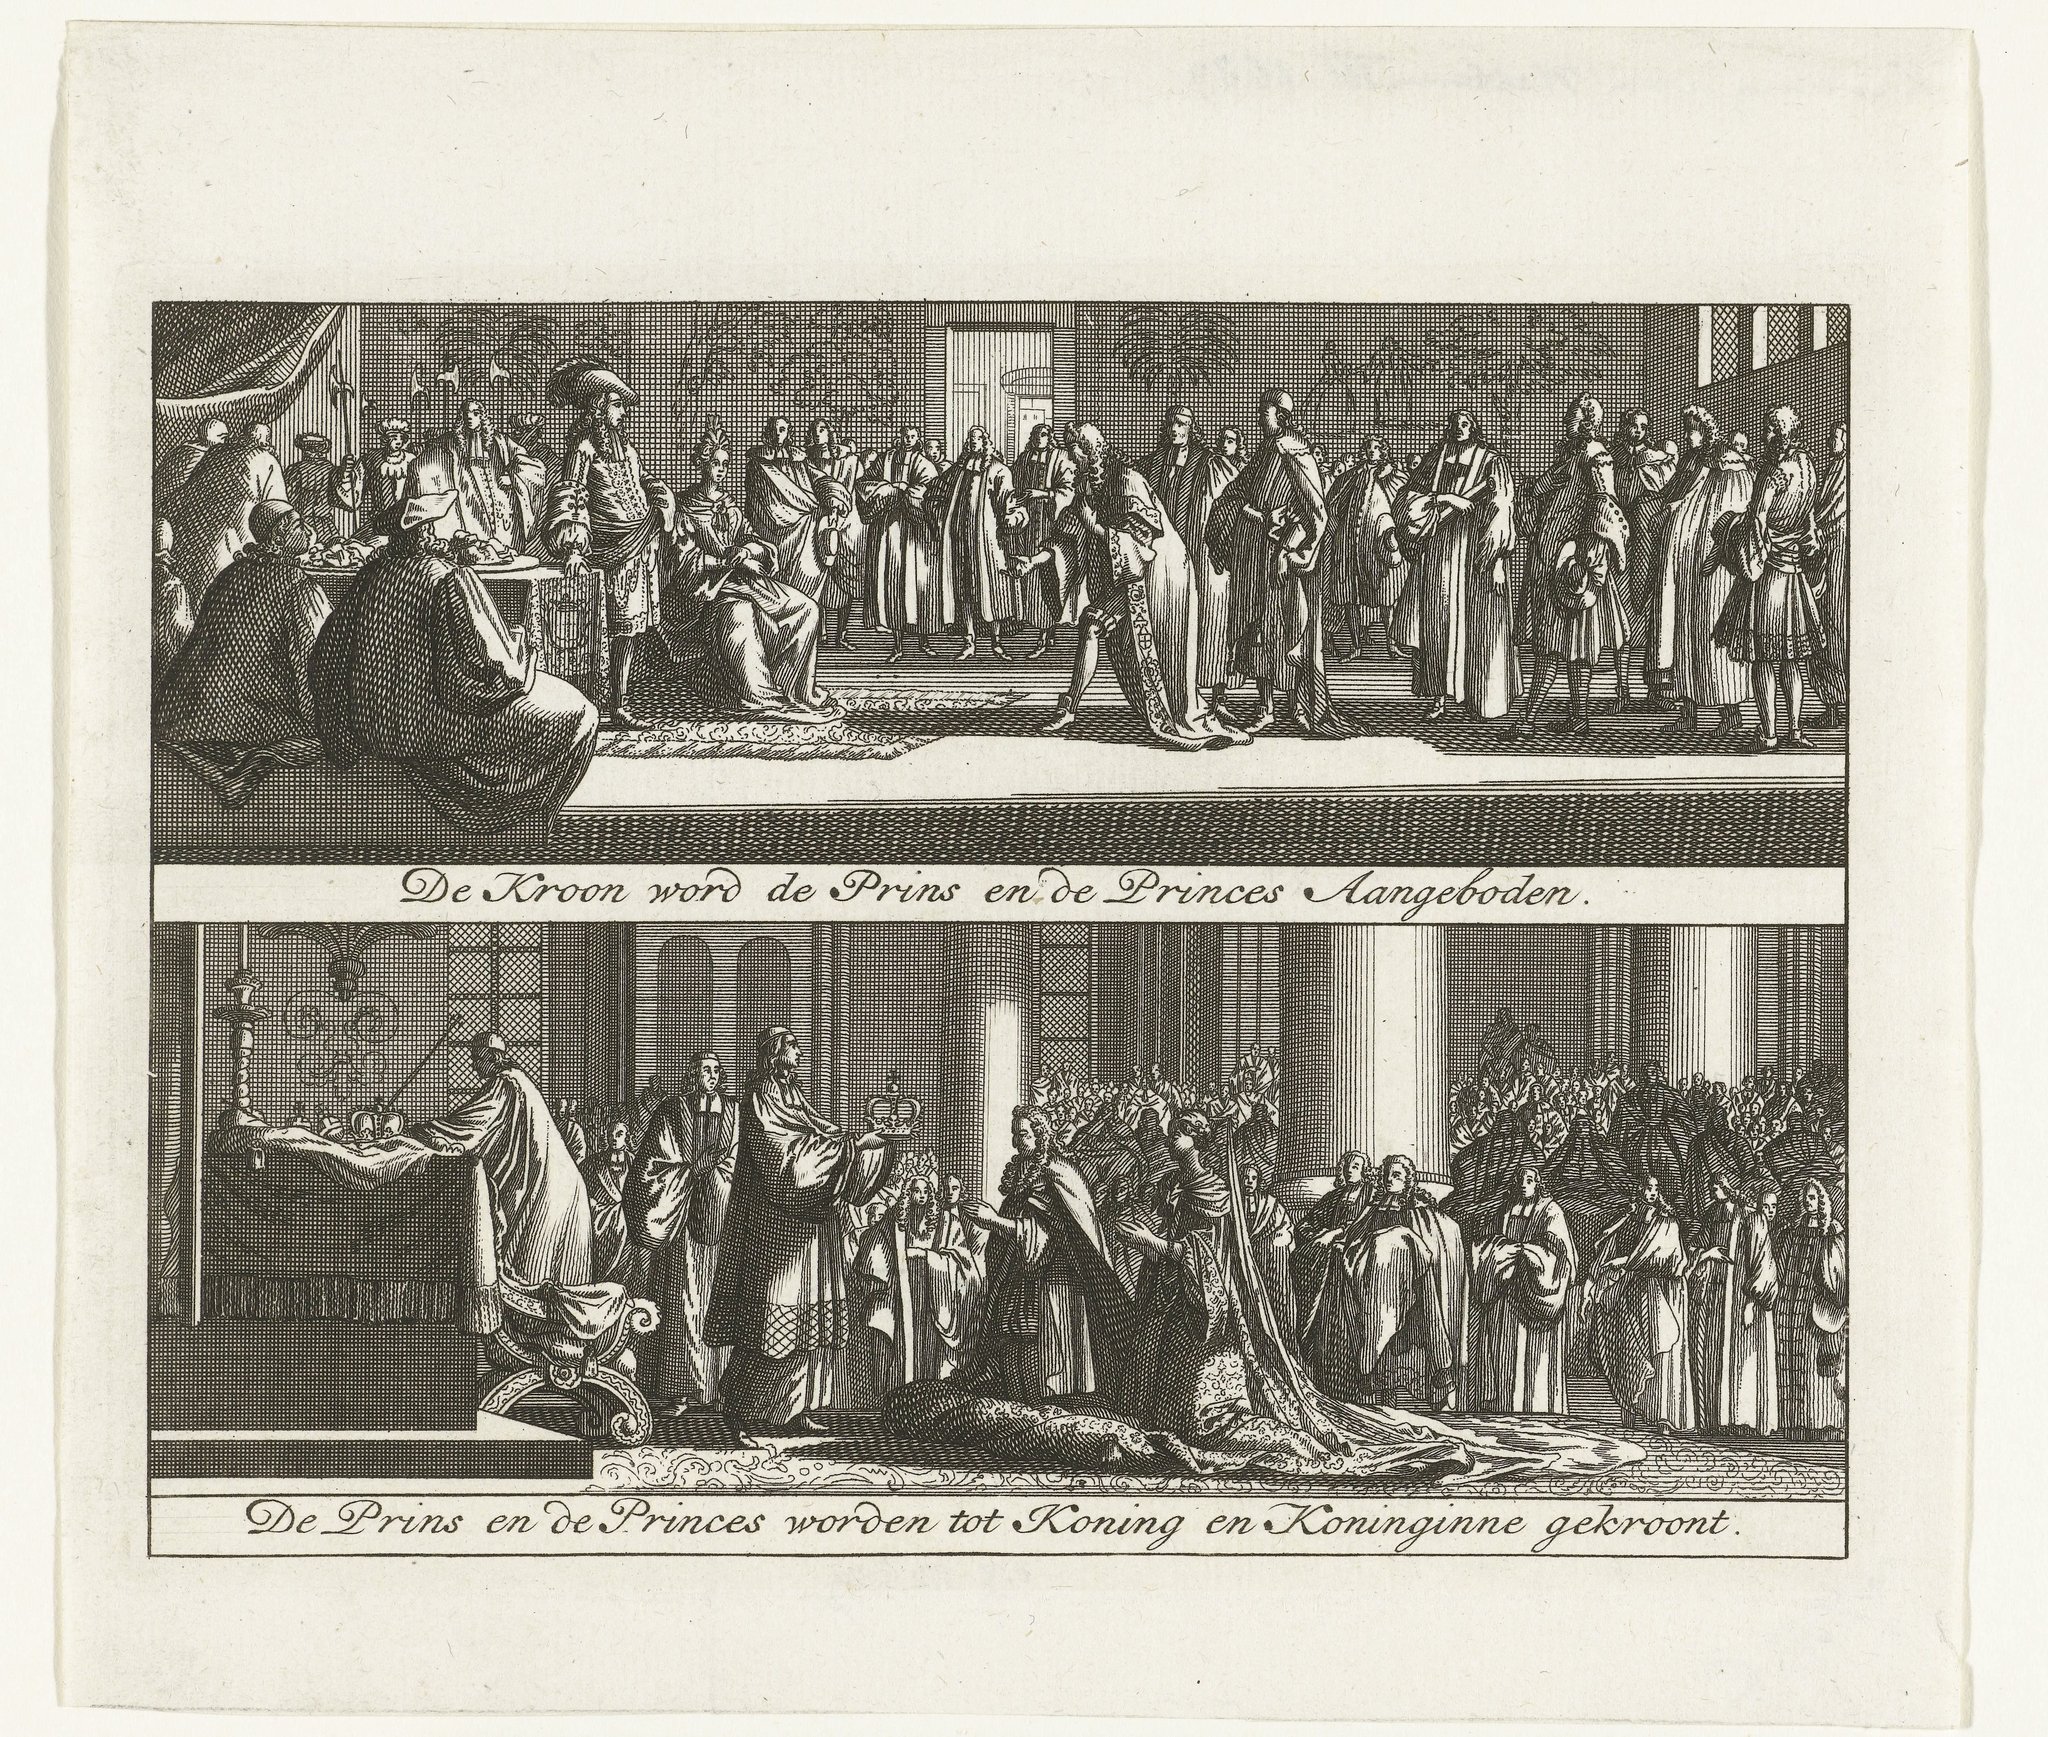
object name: print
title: De Kroon word de Prins en de Princes Aangeboden / De Prins en de Princes worden tot Koning en Koninginne gekroont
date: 1689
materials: paper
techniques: etching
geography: northern netherlands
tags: the hague, william iii (prince of orange and king of england, scotland, and ireland), london, maria ii stuart (koningin van engeland, schotland en ierland), during the coronation, westminster abbey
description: Zie ook FMH 2740A. Volgens een notitie in het klappertje bij dit nummer naar een tekening van Jan Luyken in de verzameling Perman in Stockholm, maar te beoordelen naar de bijgevoegde foto van deze tekening is dat echter niet het geval. Niet in Frederik Muller; door het RPK toegevoegd nummer.